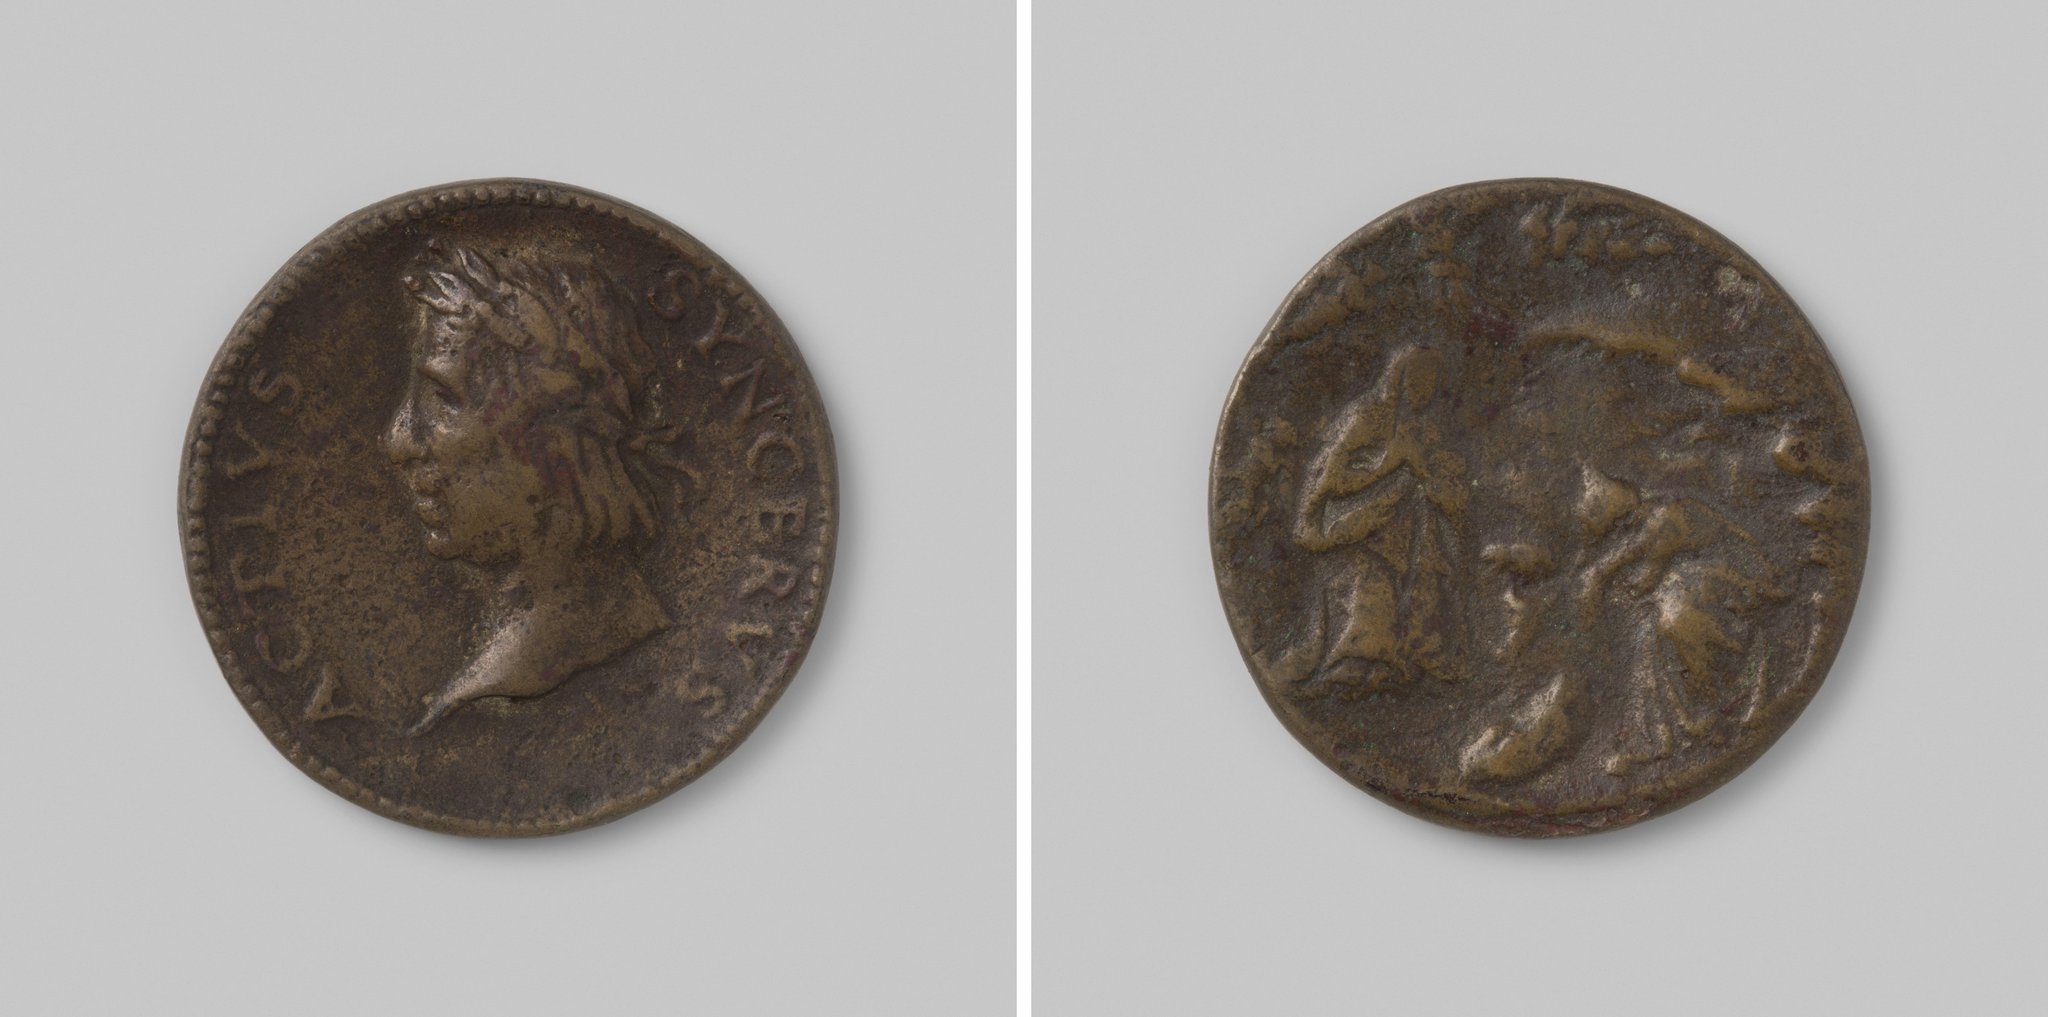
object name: history medal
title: Jacopo Sannazaro, dichter uit Napels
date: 1524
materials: bronze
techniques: striking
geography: italy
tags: naples, rome, jacopo sannazaro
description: Bronzen penning. Voorzijde: borststuk man met lauwerkrans binnen omschrift. Keerzijde: uitbeelding van werk van Sannazaro: Maria, Jozef en engelen aanbidden Christus-kind.